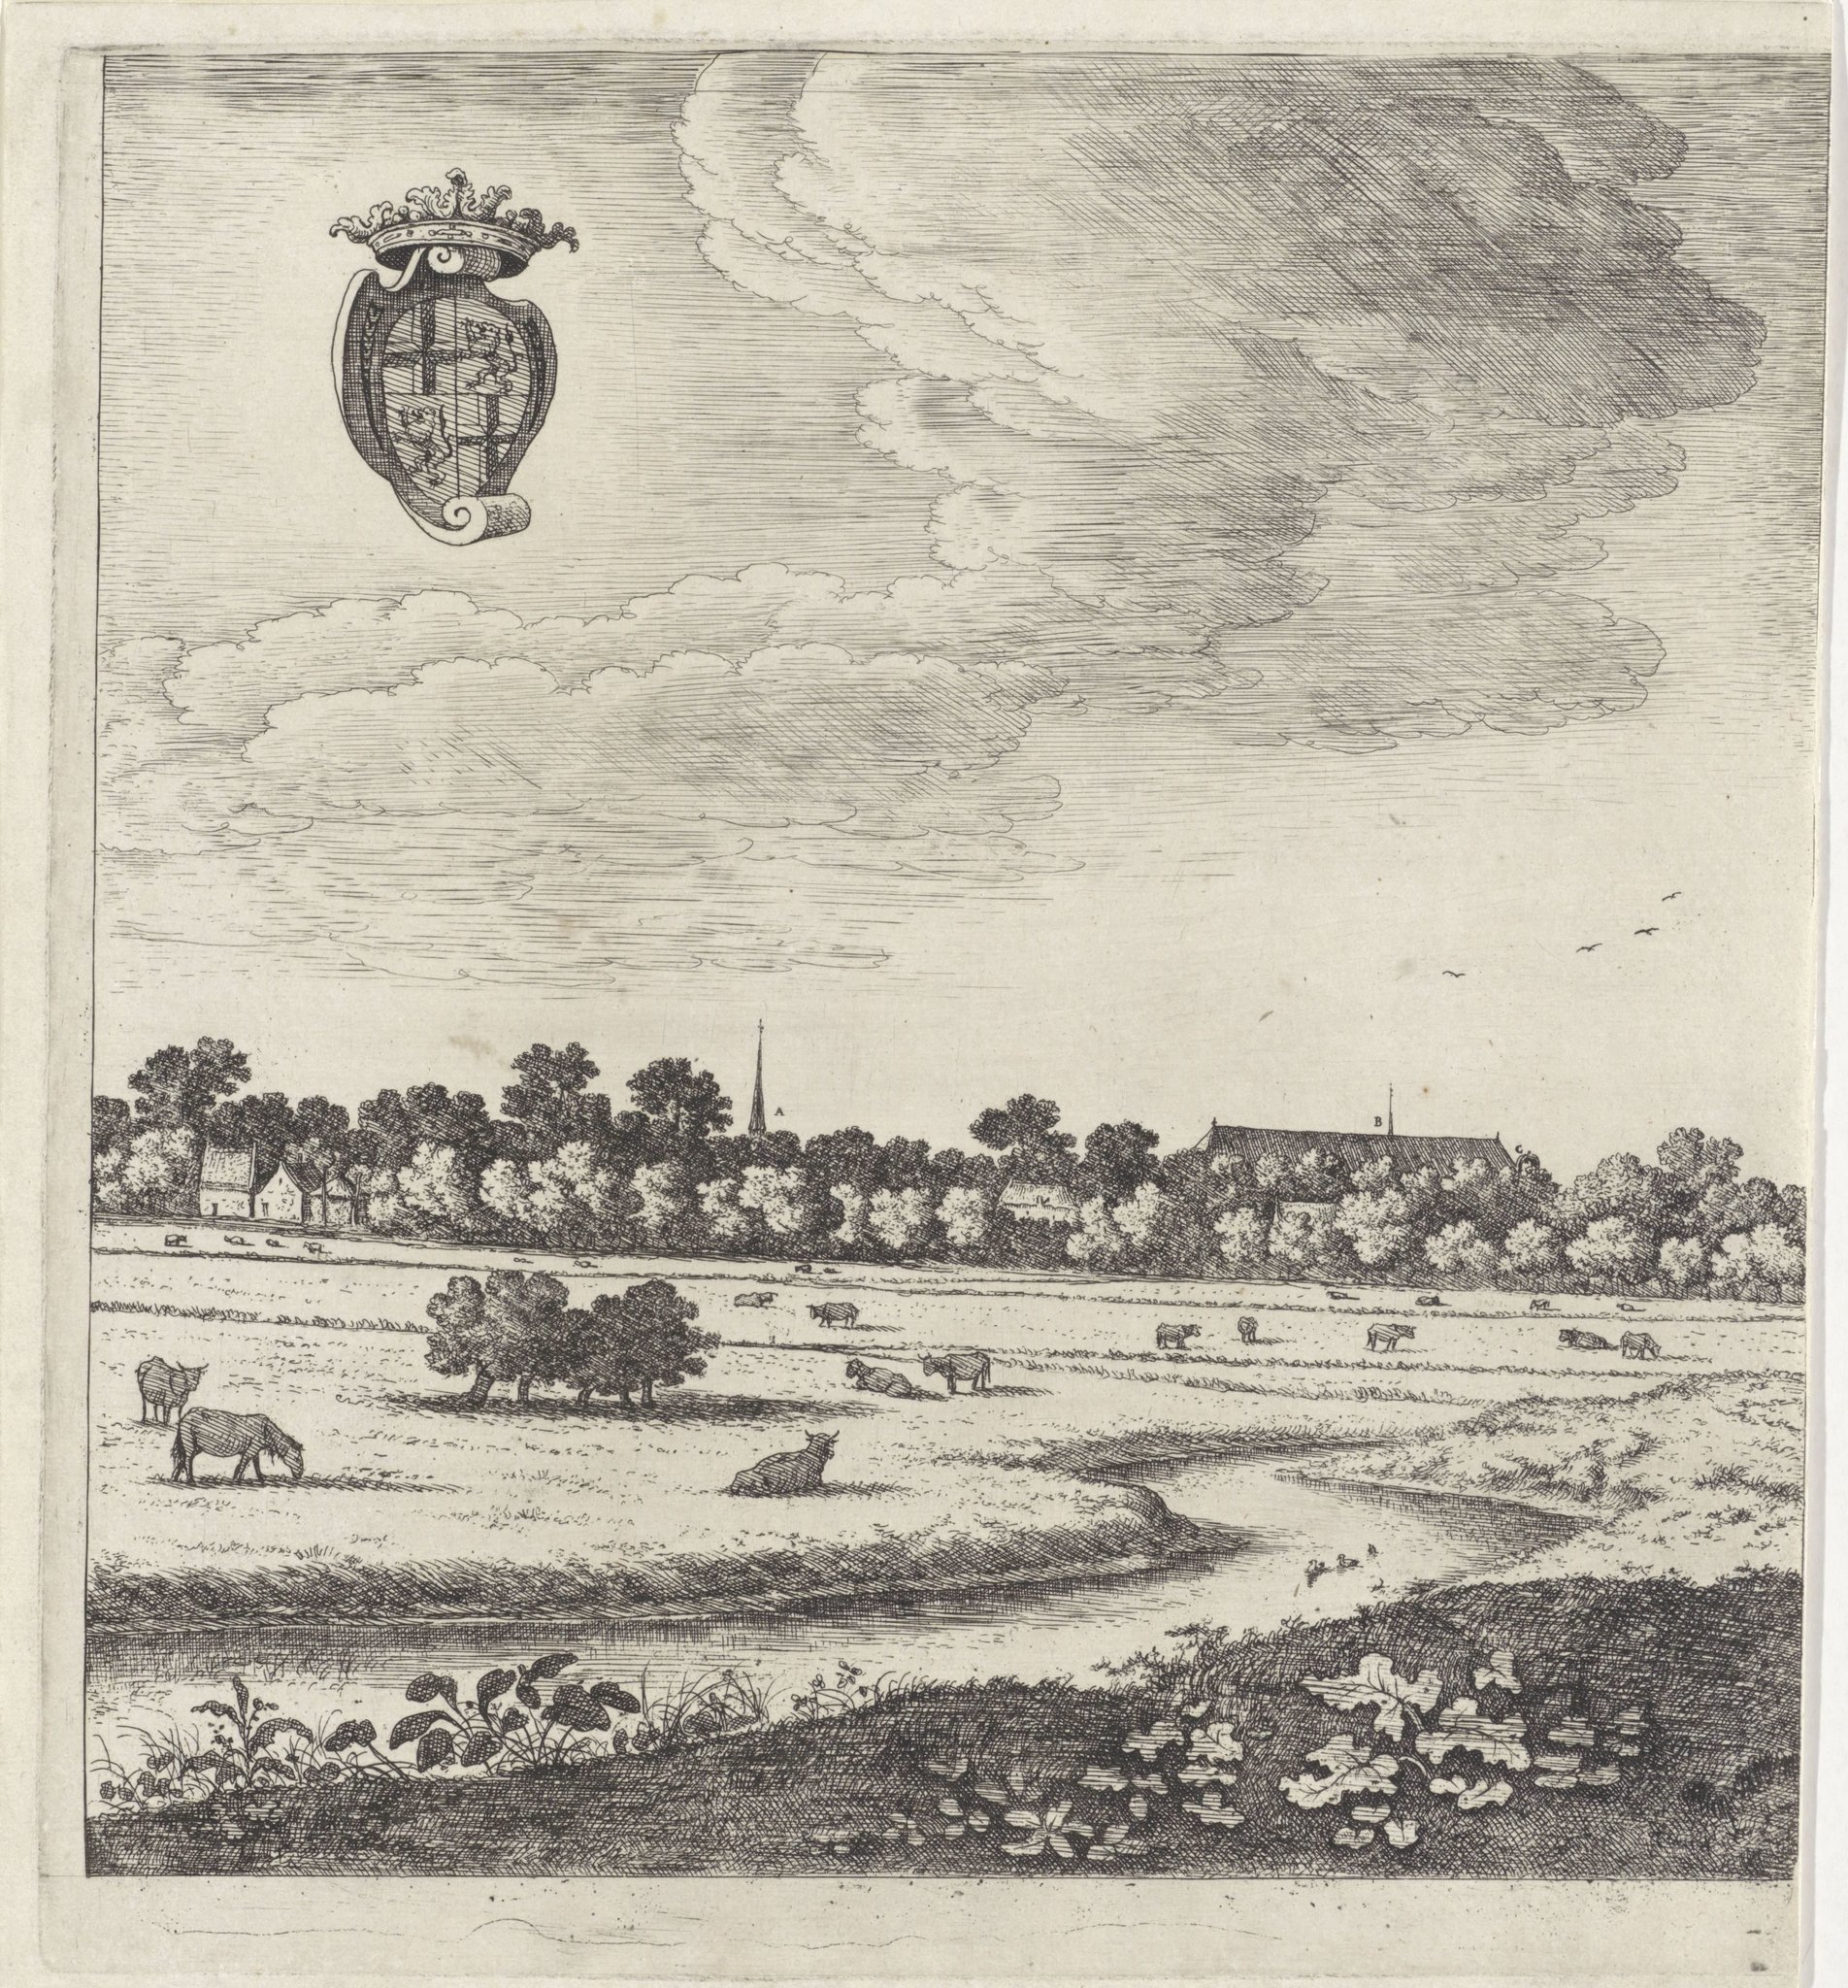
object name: print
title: Gezicht op Utrecht, (plaat I)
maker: herman saftleven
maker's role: draughtsman, painter, print maker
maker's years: 1609-1685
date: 1648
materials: paper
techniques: etching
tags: cow, church (exterior), utrecht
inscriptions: date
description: Linkerplaat van 'Gezicht op Utrecht' met een gedeelte van Utrecht. Op de voorgrond weilanden met koeien en een meanderende sloot. Iets meer naar de achtergrond een bomenrij waaraan boerderijen en twee kerken liggen.